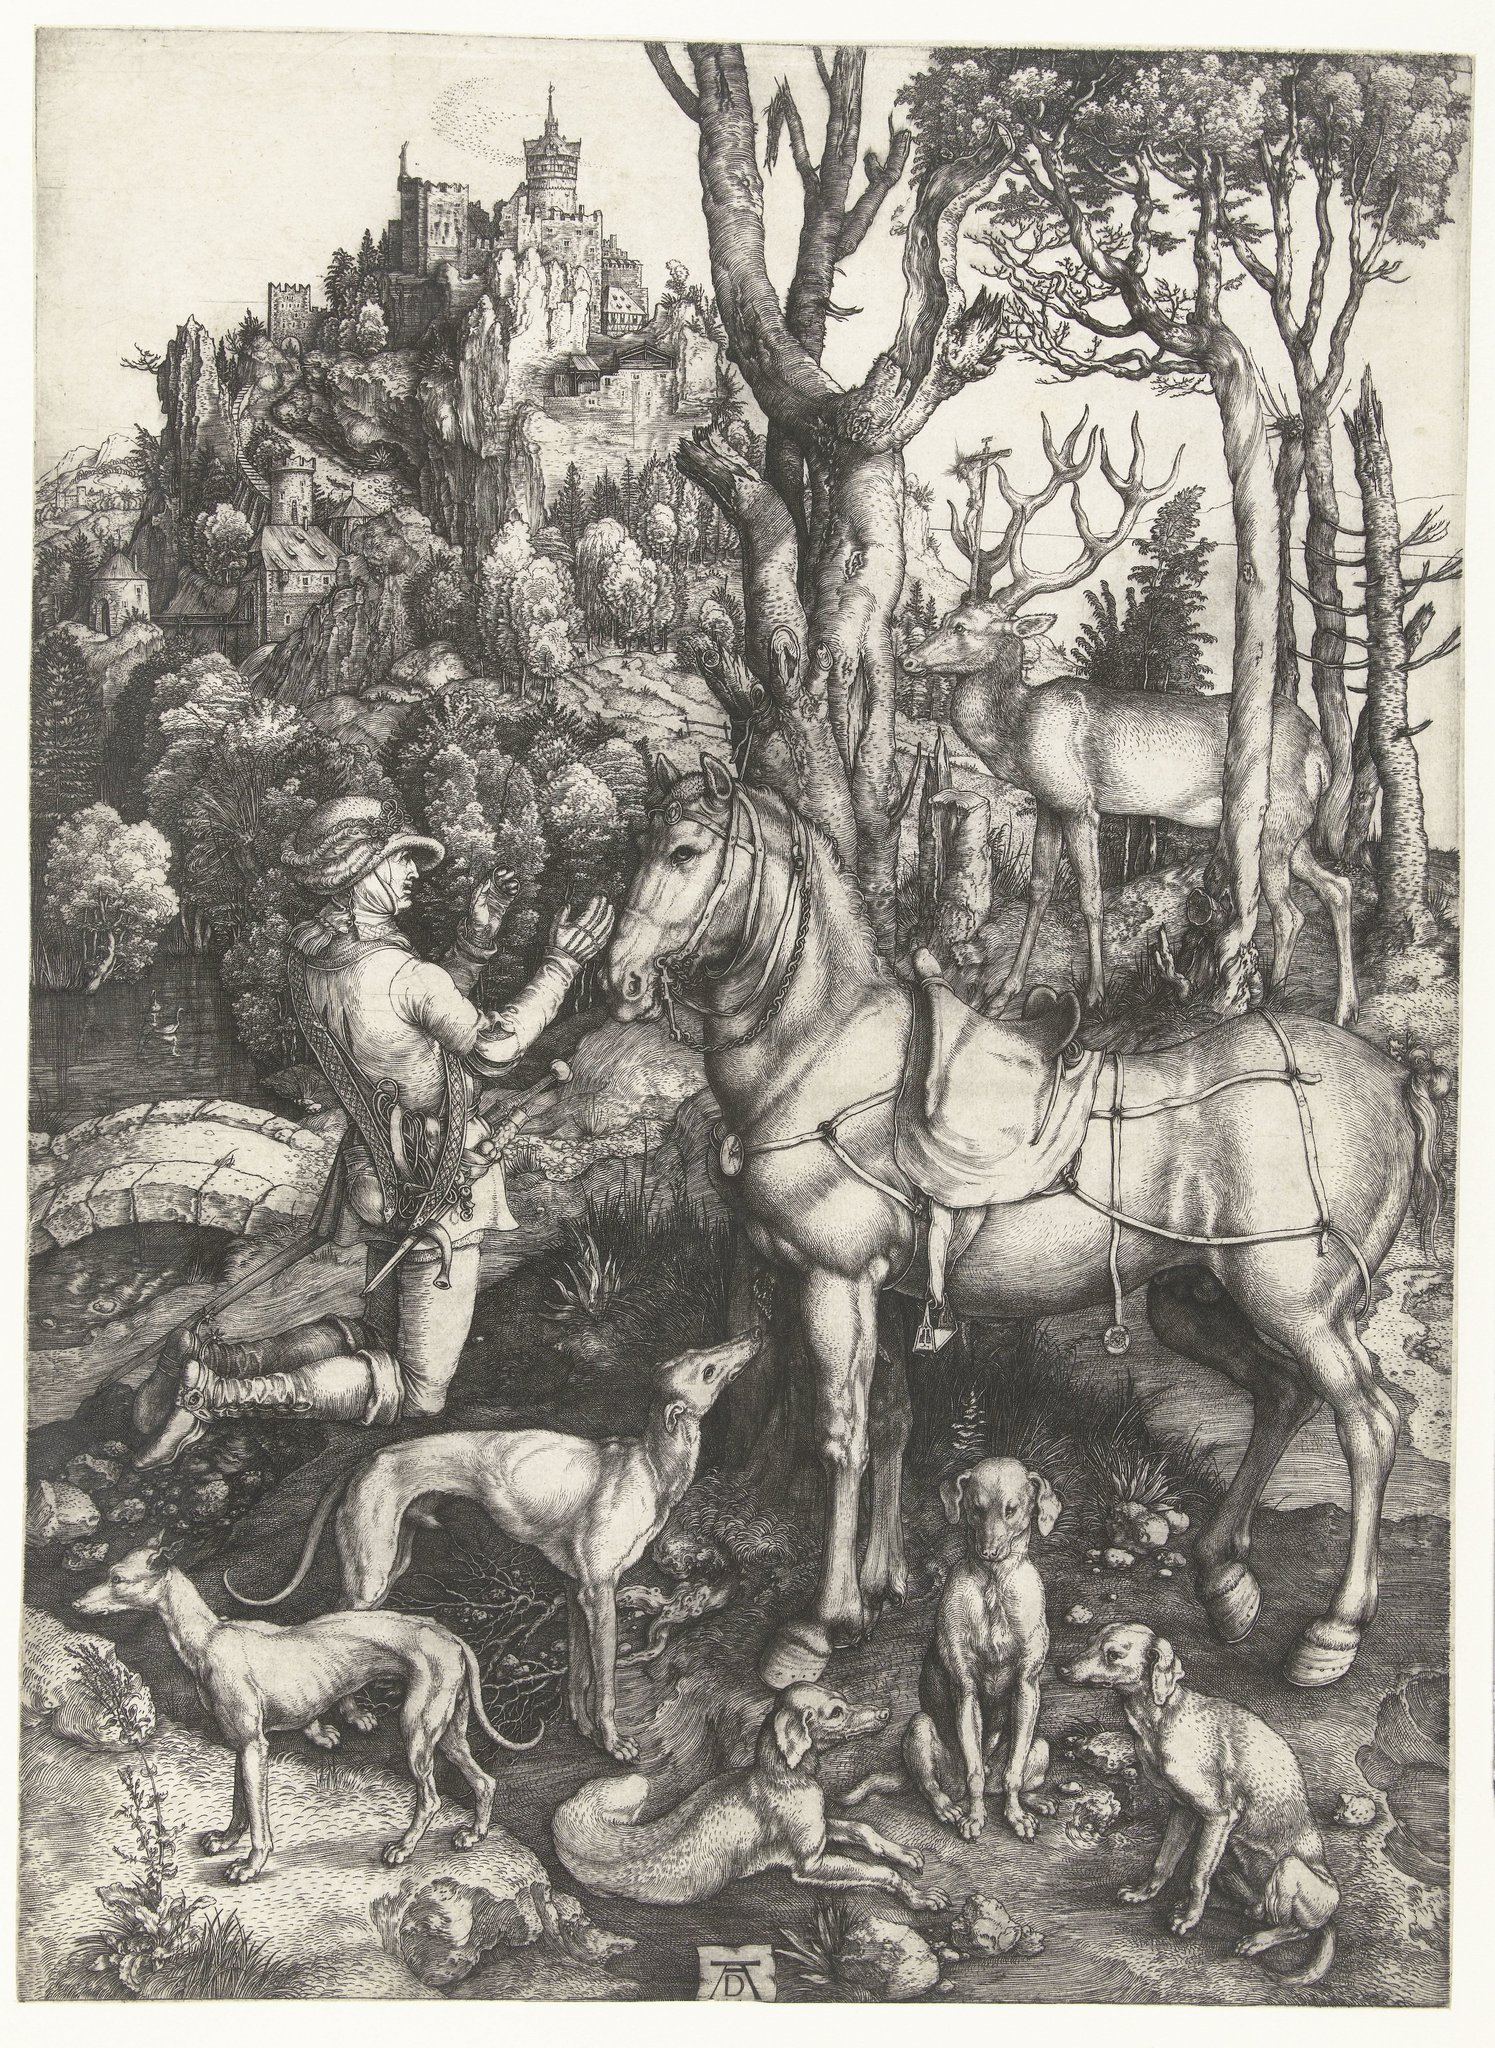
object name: print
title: The Vision of St Eustace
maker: albrecht dürer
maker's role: draughtsman, painter, print maker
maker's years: 1471-1528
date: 1499-1503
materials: paper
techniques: engraving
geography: nuremberg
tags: the conversion of st. eustace: while hunting (on horseback) he is confronted with a stag bearing a crucifix between its antlers; eustace is shown kneeling before the stag (that appears on a rock)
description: The Roman commander Placidus is hunting a stag, when it suddenly stands still. In a vision he sees a crucifix lodged between its antlers, and the stag speaks to him in Christ’s voice. Placidus converts and changes his name to Eustace. Dürer counted this print among his best works, and repeatedly gave impressions of it to friends and acquaintances.